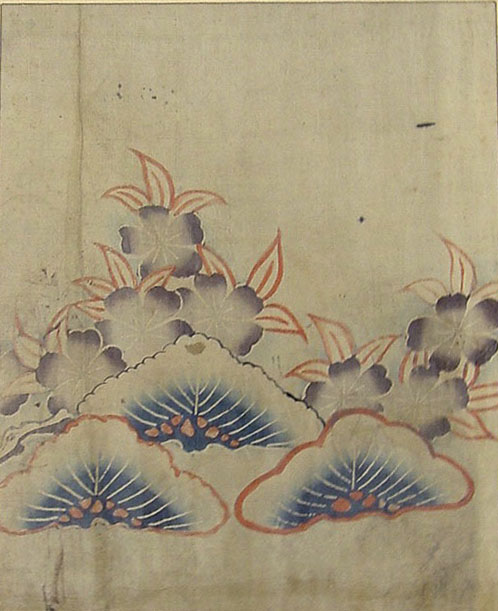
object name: piece from a kosode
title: Piece from a Kosode with Pine Boughs and Cherry Blossoms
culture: japanese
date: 1615-1868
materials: silk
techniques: dyeing, painting, weave, resist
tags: flowers